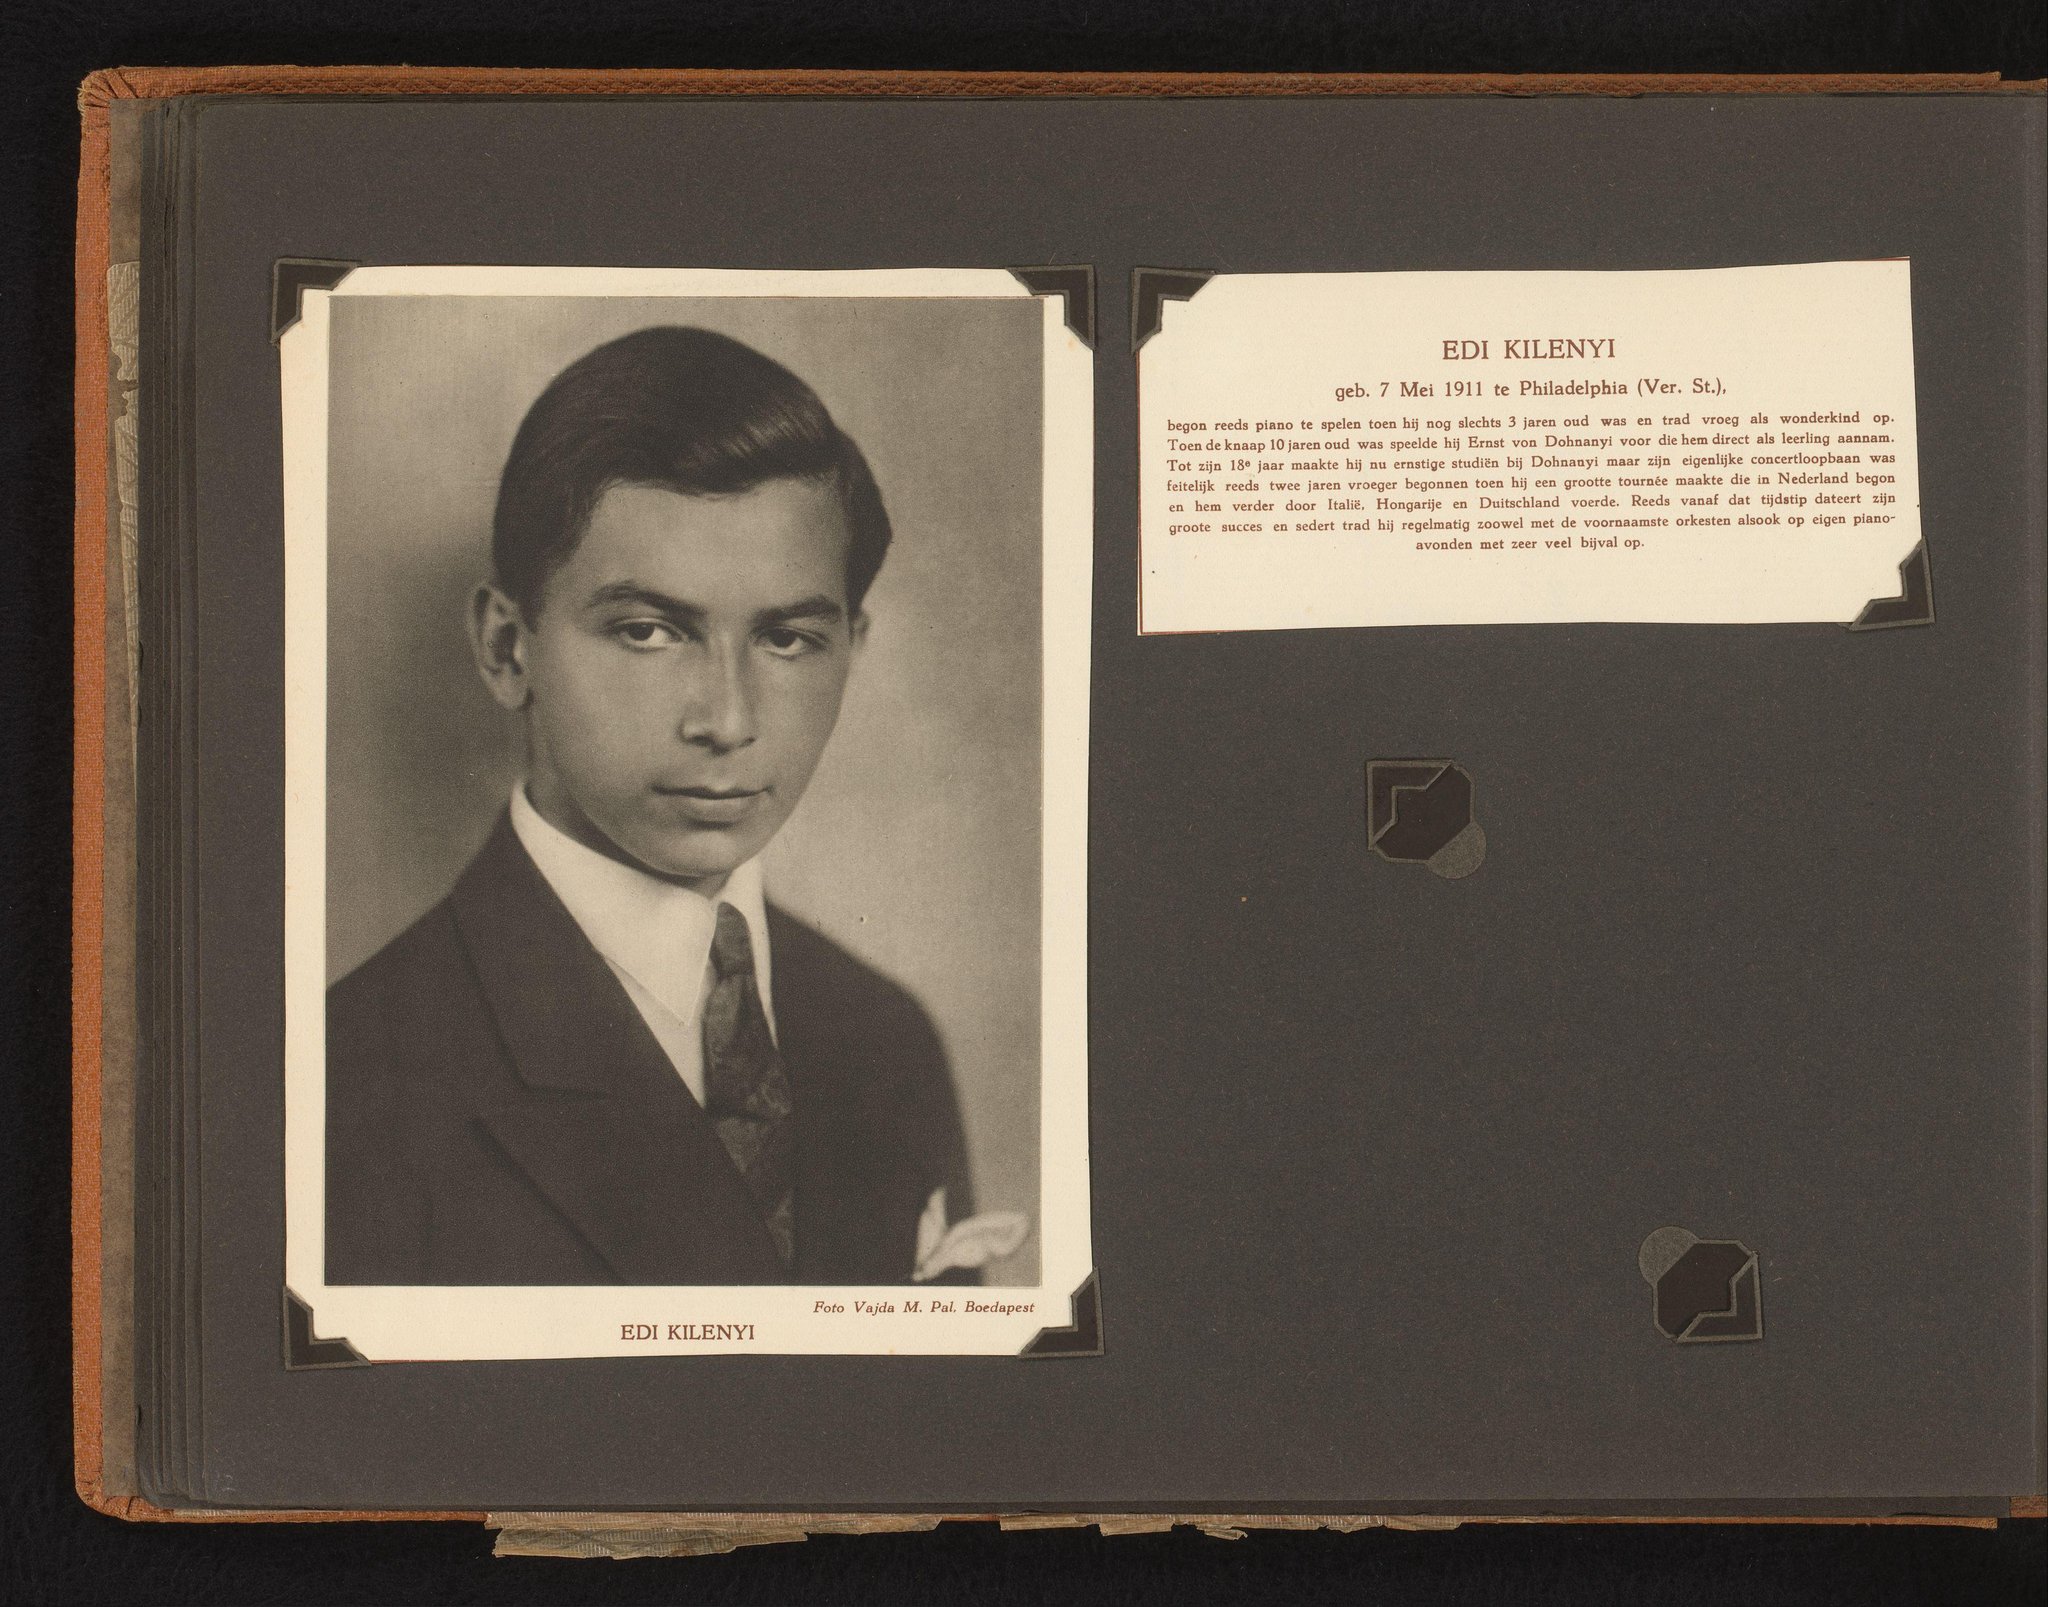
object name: album leaf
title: Edward Kilenyi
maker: manó pál vajda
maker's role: fotograaf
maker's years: 1874-1945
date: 1933-1936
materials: paper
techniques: rotogravure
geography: budapest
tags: portrait of composer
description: Albumblad met een portret van en een tekst over de componist Edward Kilenyi. Onderdeel van het Esperanto album uit ca. 1933-1936.